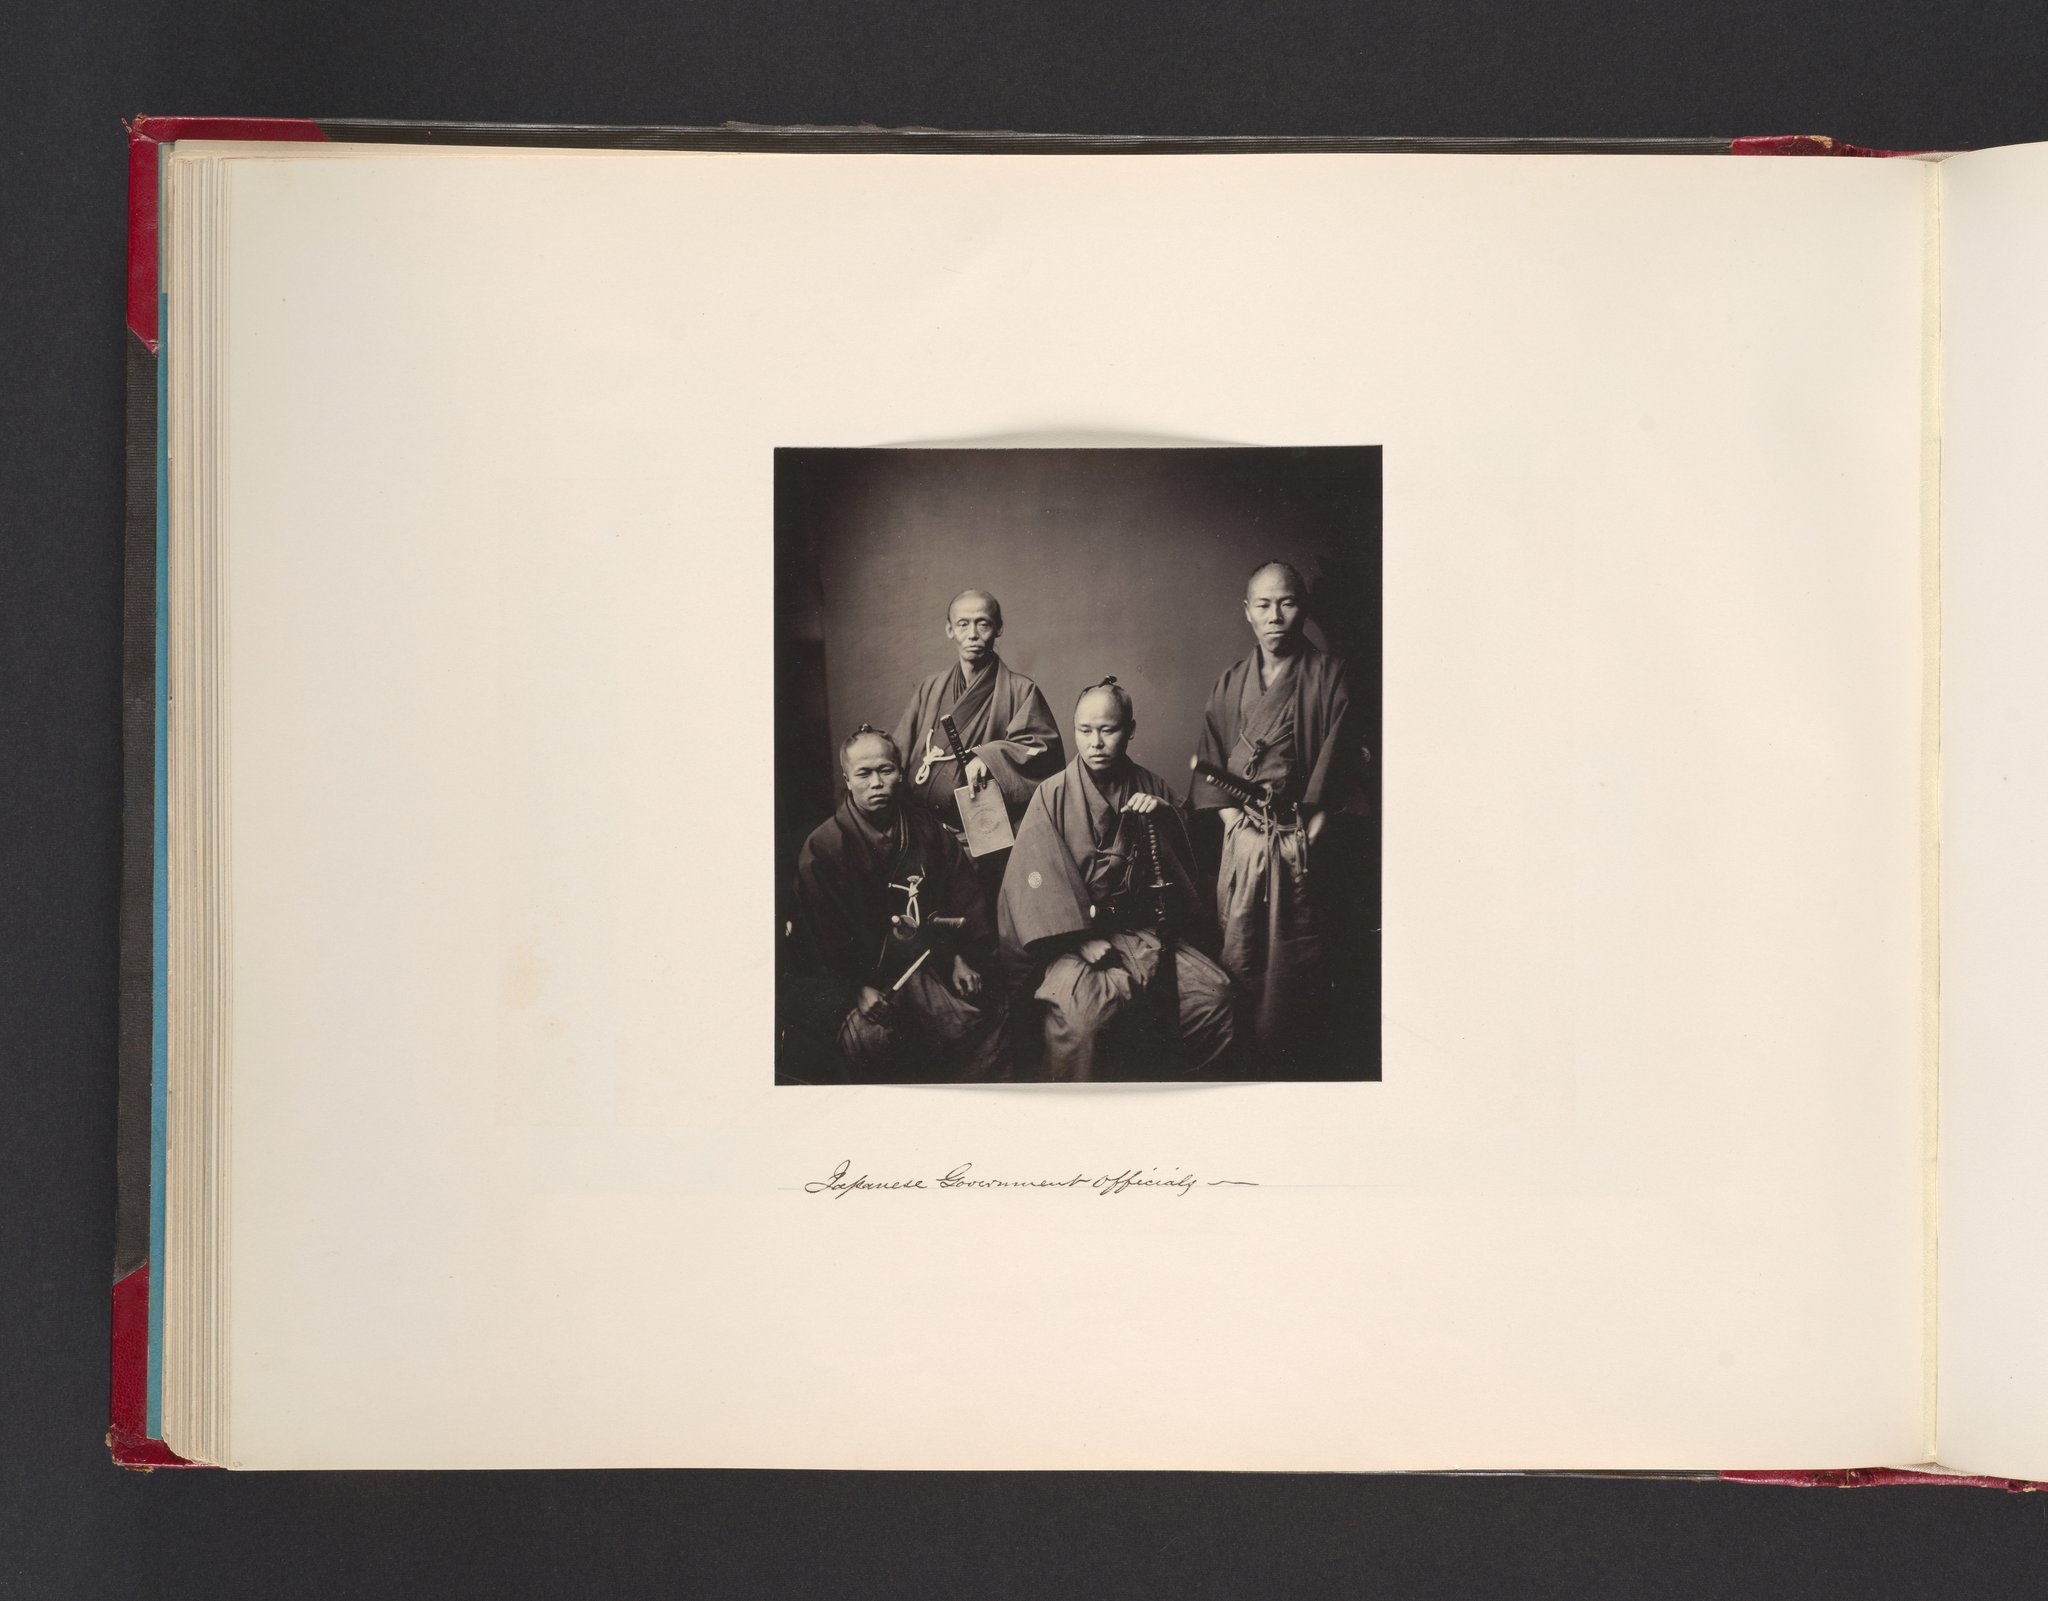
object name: photograph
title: Japanese Government Officials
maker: john thomson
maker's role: artist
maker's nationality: british, scottish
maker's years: 1837-1921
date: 1865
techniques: albumen silver print, glass negative